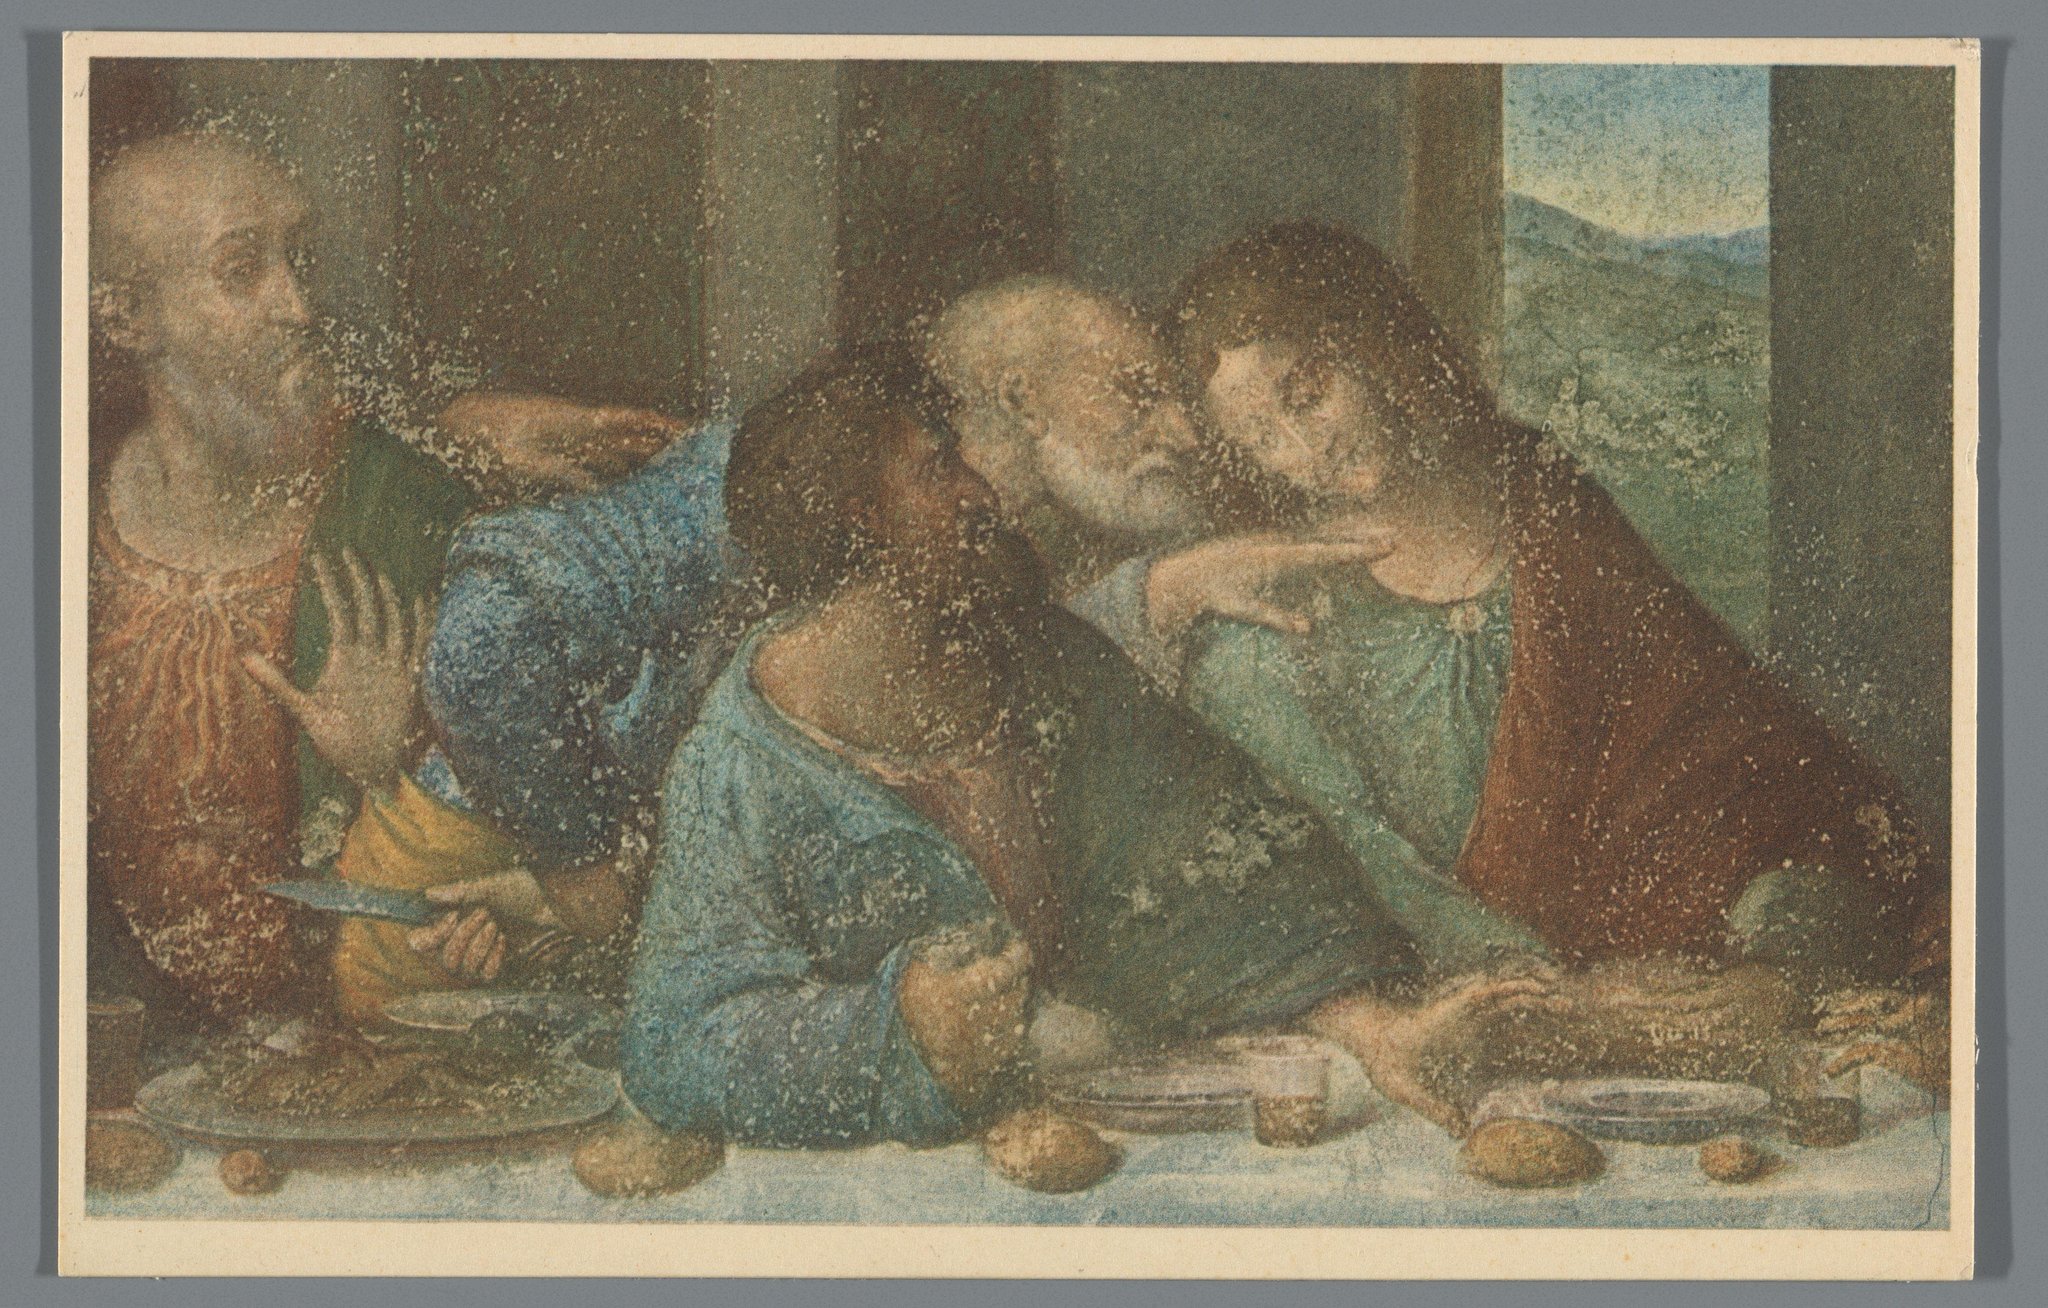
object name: ansichtkaart, prentbriefkaart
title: Ultima cena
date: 1900-1930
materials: paper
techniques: photograph, lithograph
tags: the episode of the last supper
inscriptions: number: ‘N. 69’, inscription: ‘R.R. GALLERIE E MONOMENTI DI LOMBARDIA/ MILANO’